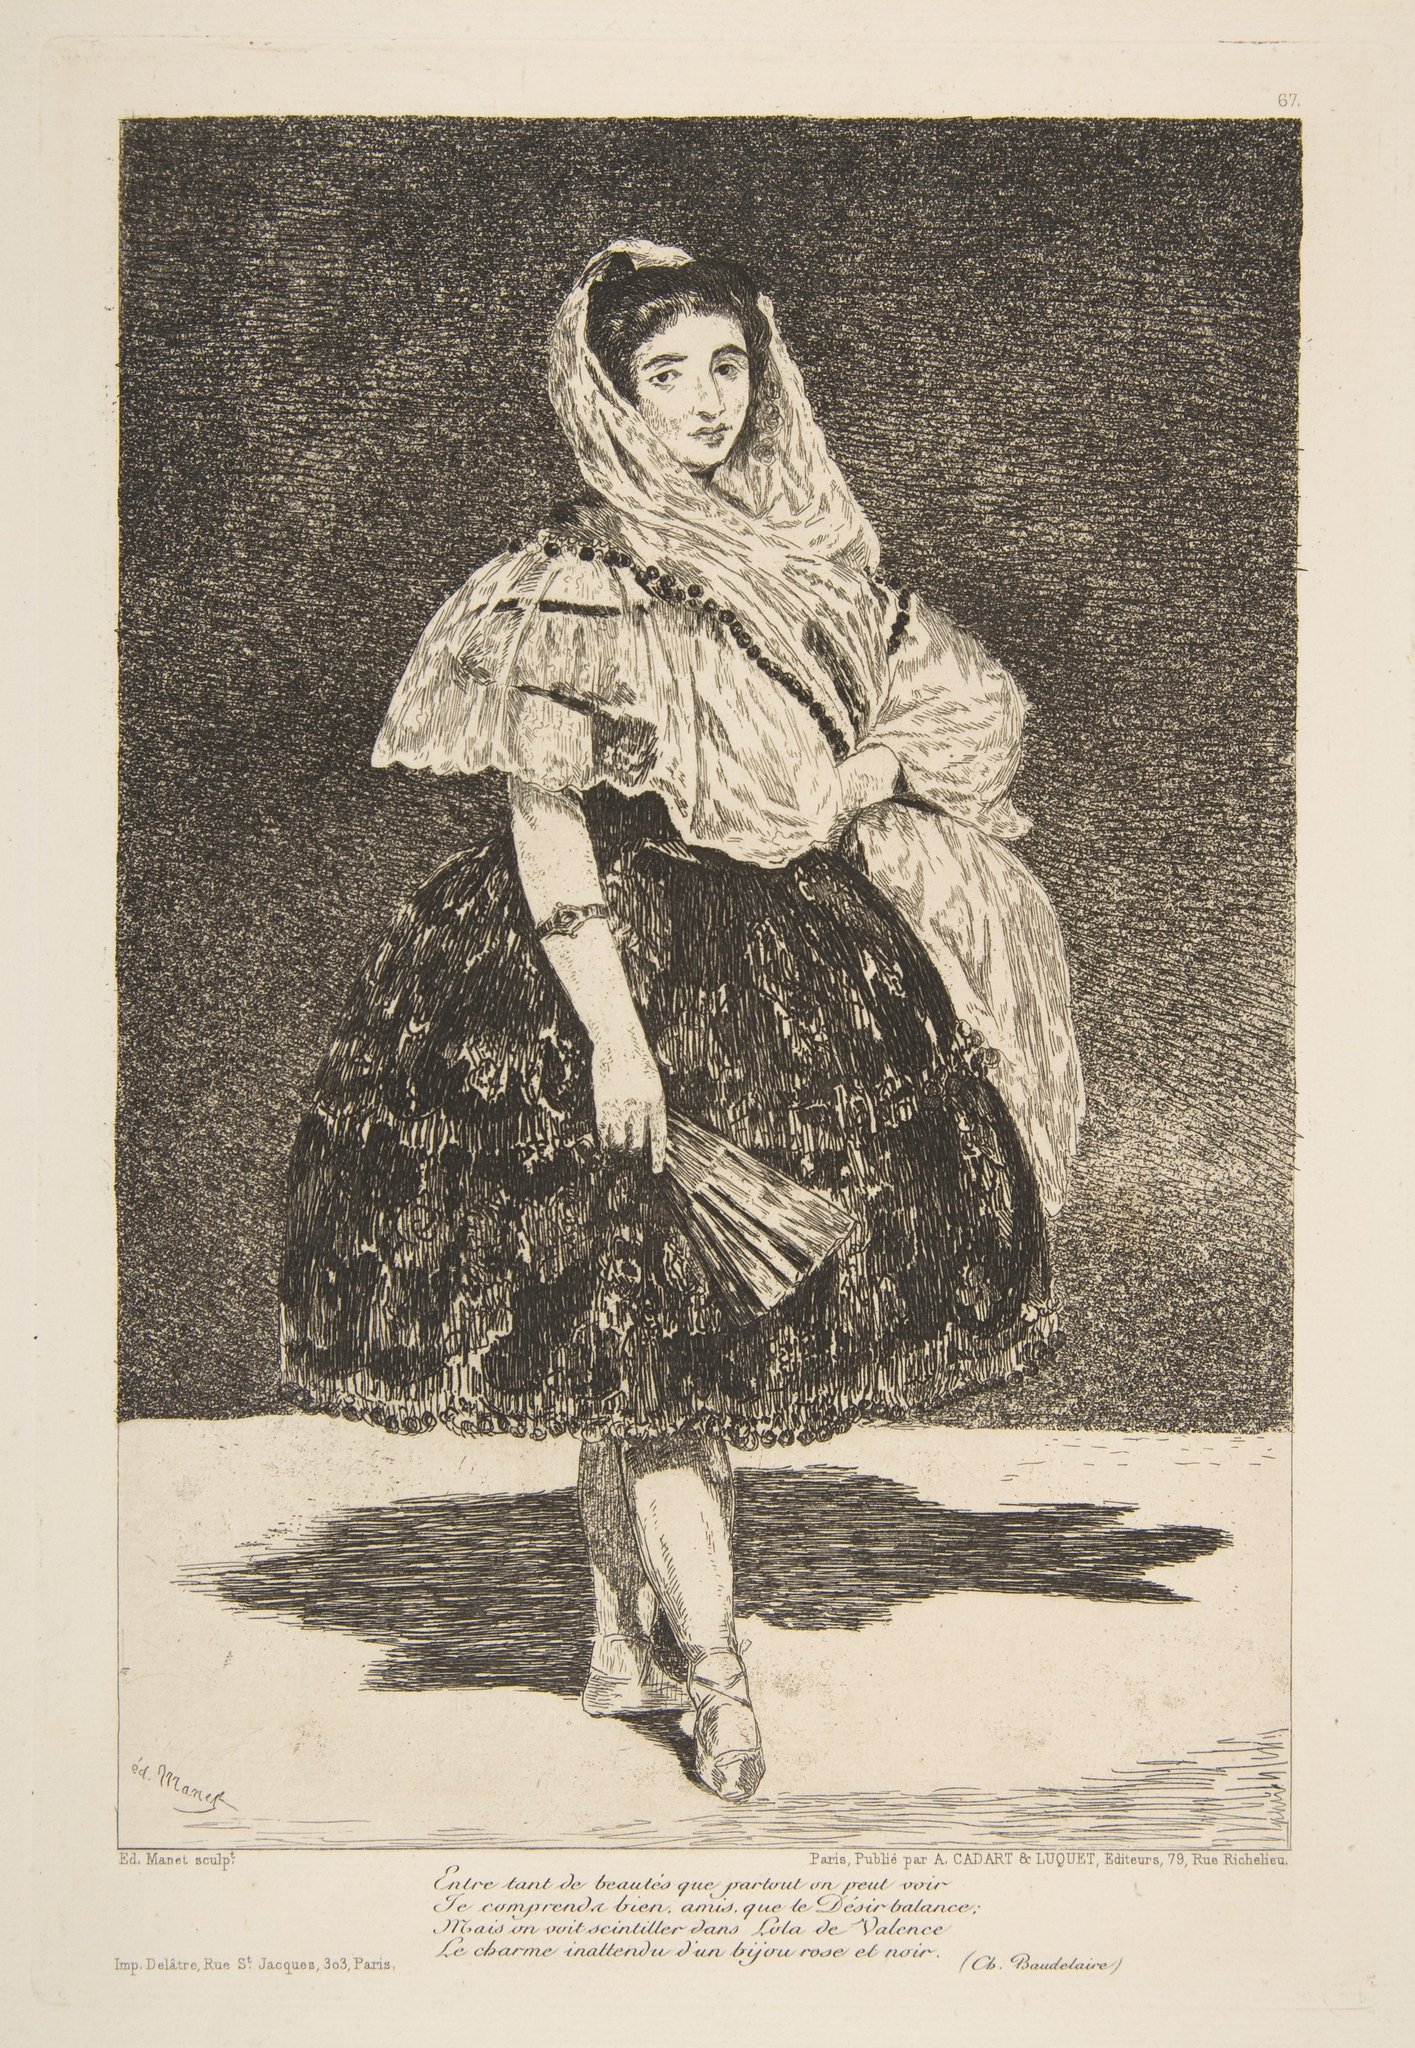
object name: print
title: Lola de Valence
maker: édouard manet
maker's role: artist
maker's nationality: french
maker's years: 1832-1883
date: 1863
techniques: aquatint, etching, roulette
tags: women